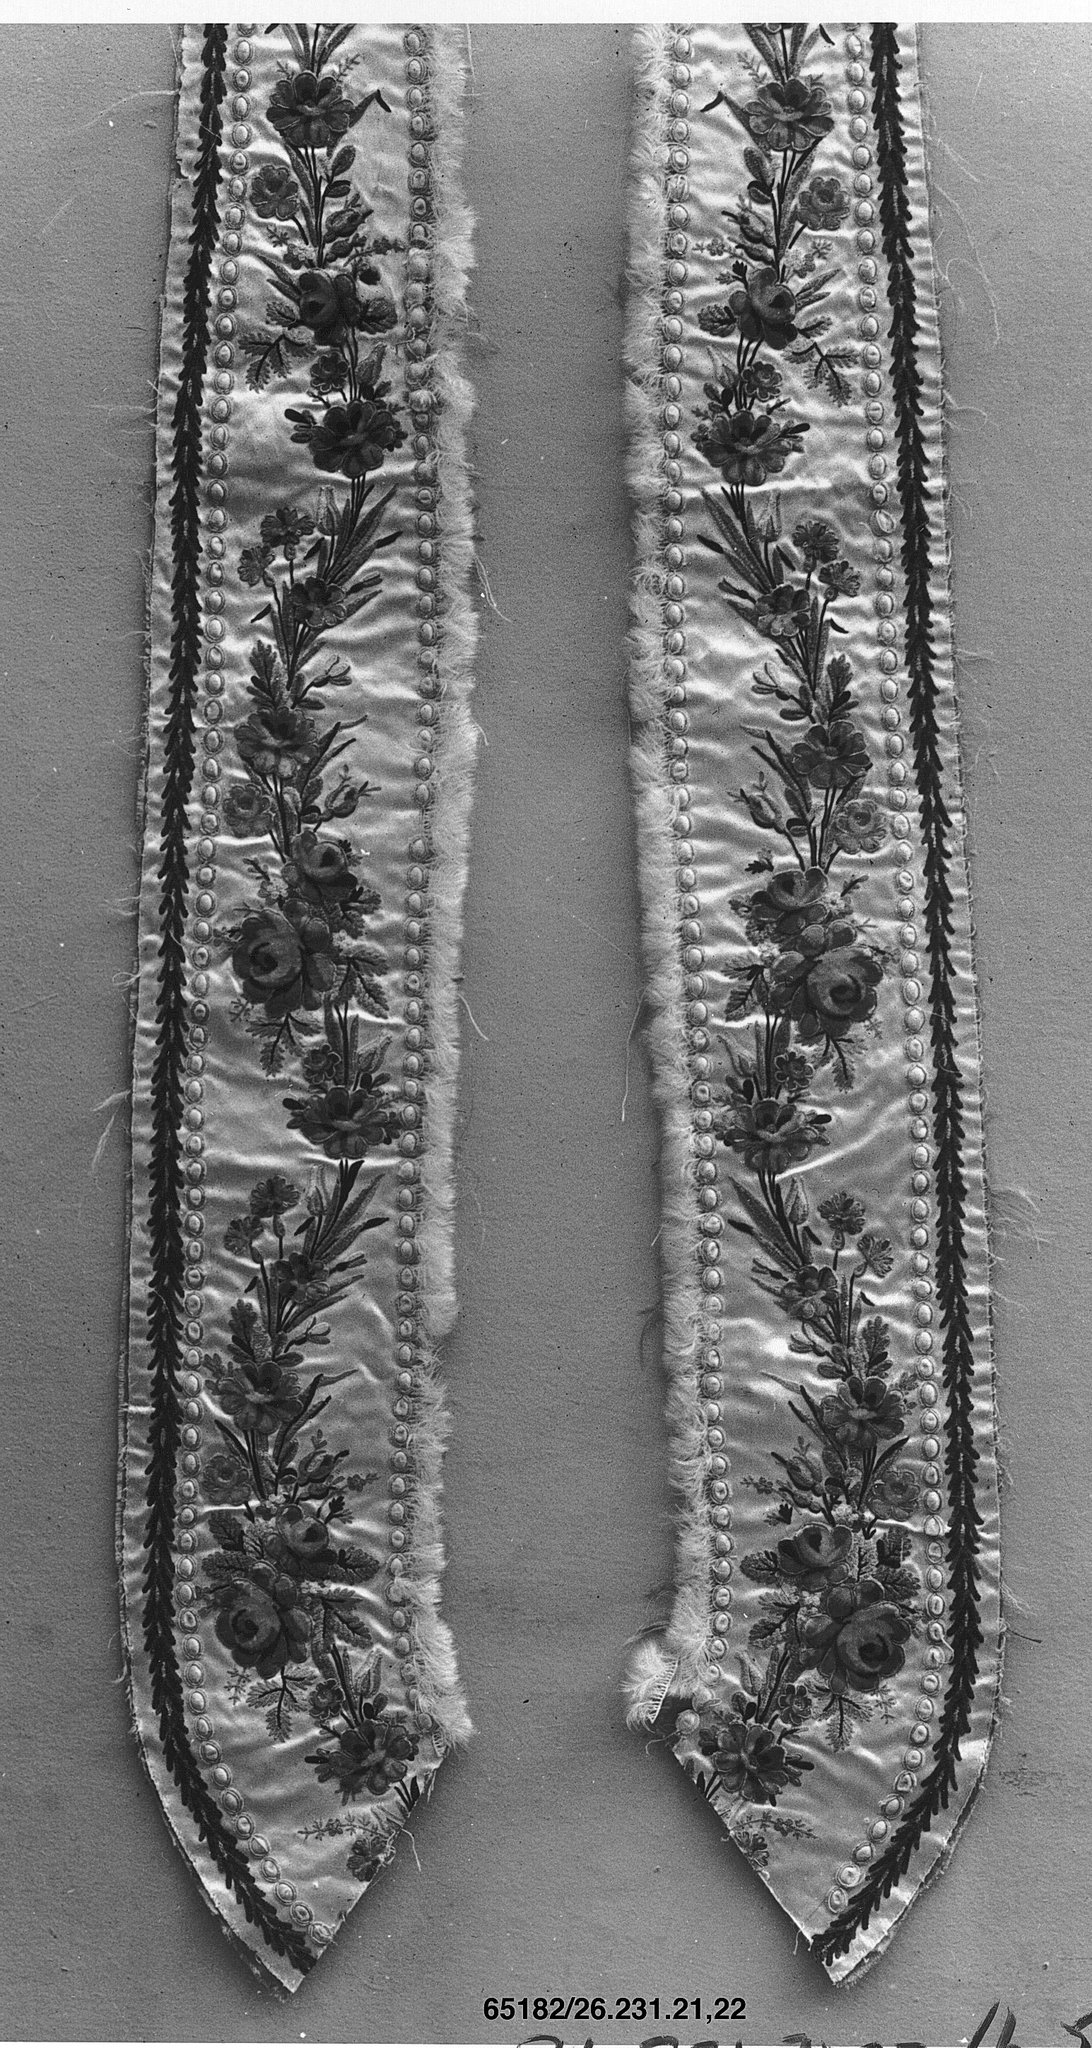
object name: dress panel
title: Dress panels (2)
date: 1830-1840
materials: silk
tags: flowers,leaves